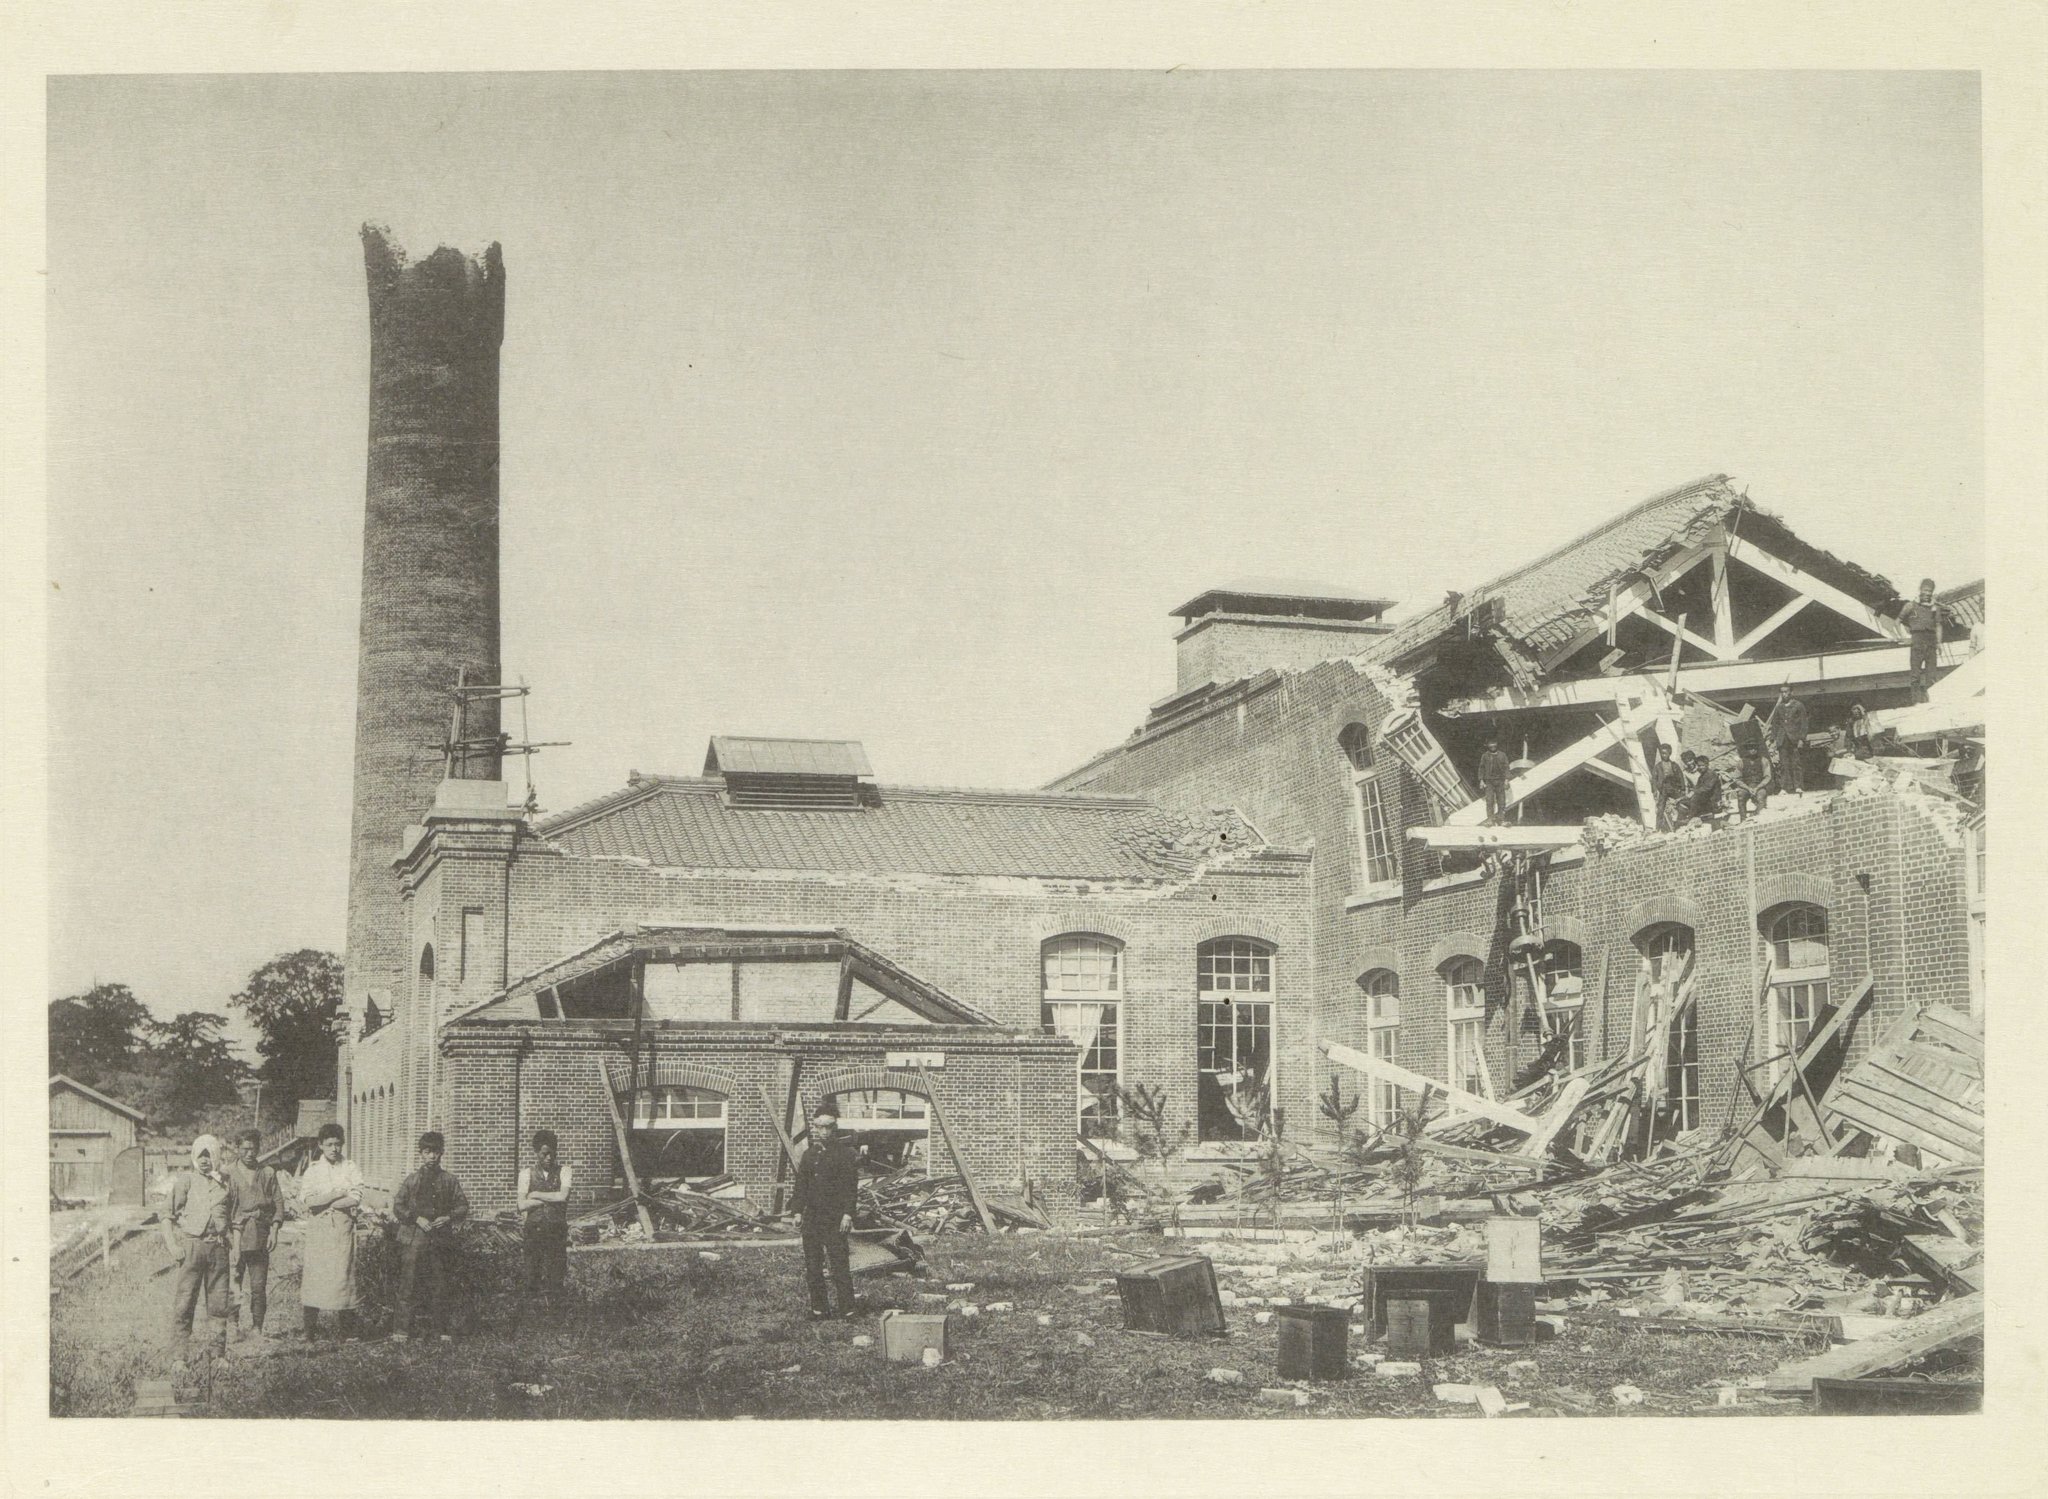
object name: photomechanical print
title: Ingestorte katoenmolen te Nagoya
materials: paper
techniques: photograph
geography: japan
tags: consequences of an earthquake, collapsing building